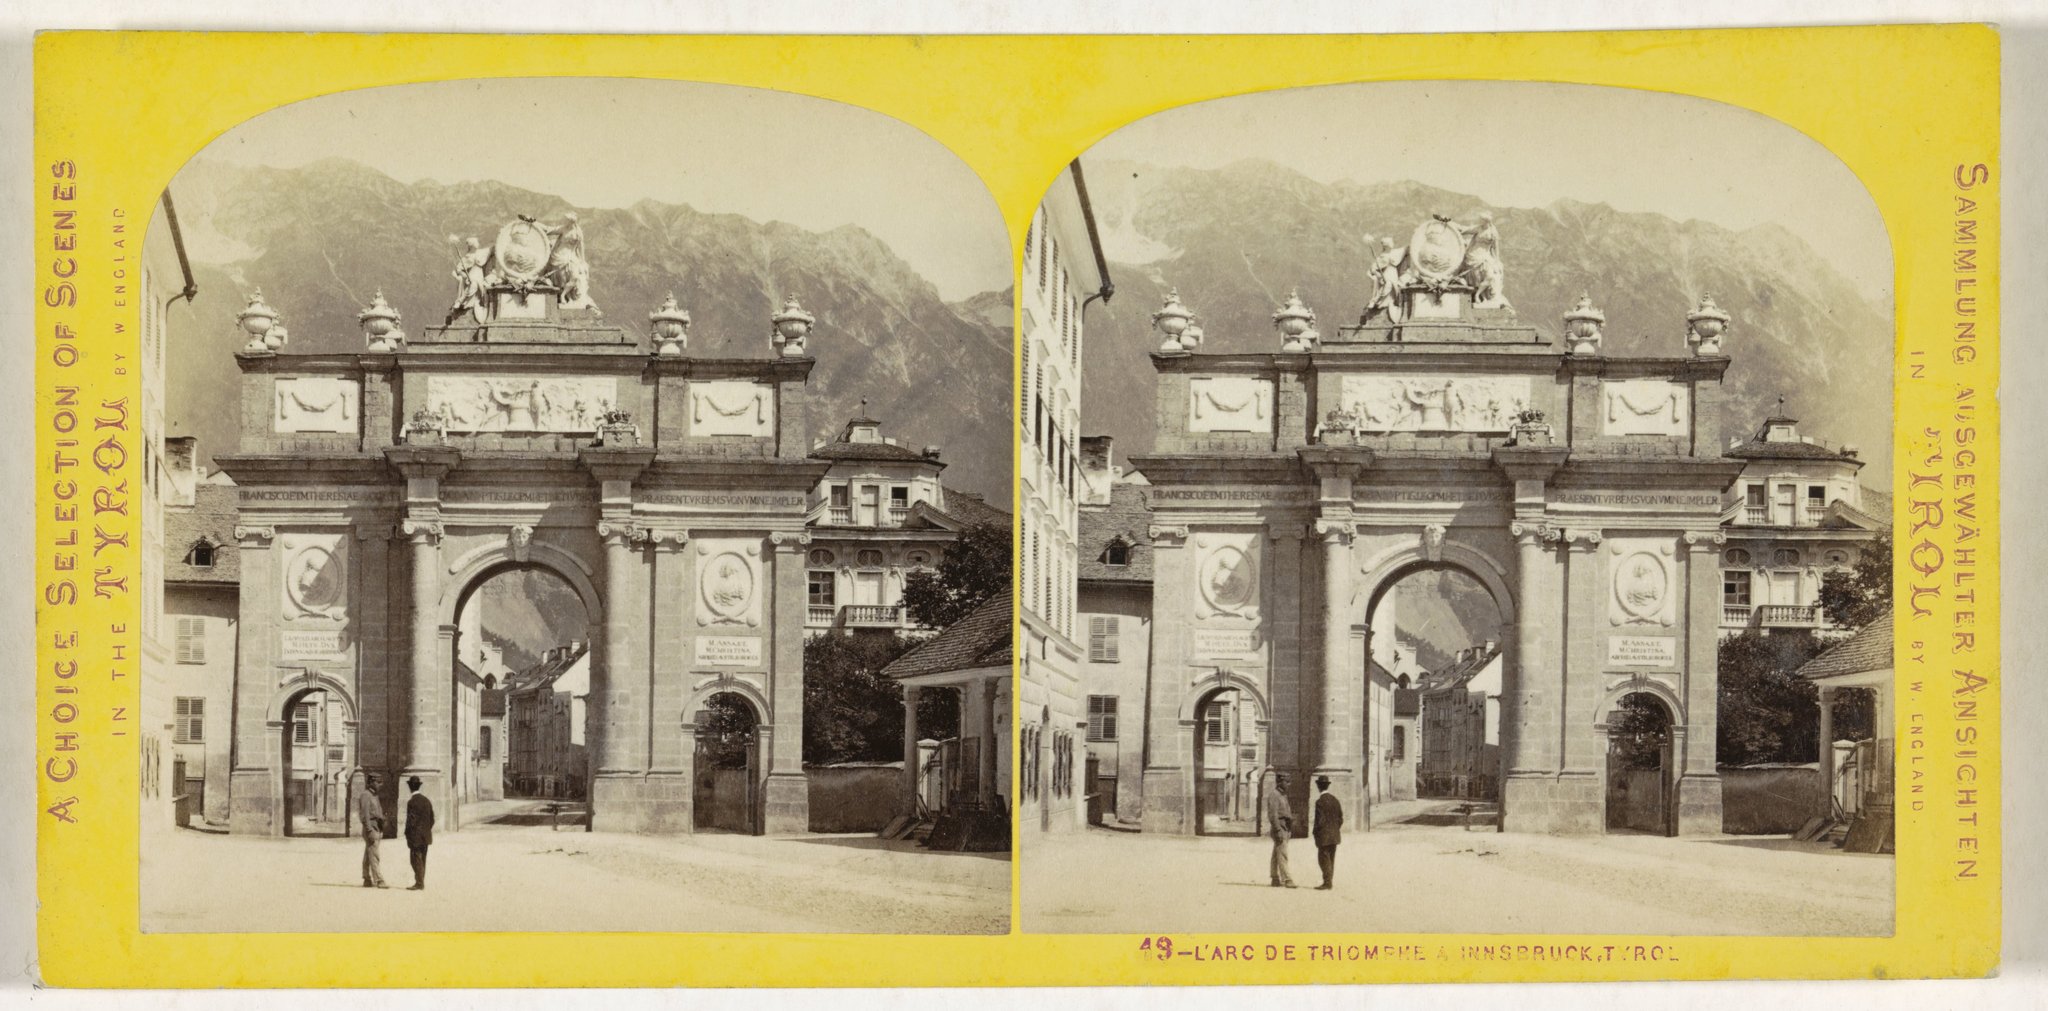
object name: stereograph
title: Triomfboog in de Maria-Theresien-Straße, Innsbruck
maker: william england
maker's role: fotograaf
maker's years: 1816-1896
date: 1863-1865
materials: cardboard, paper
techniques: albumen print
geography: innsbruck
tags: triumphal arch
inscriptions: number: ‘19’